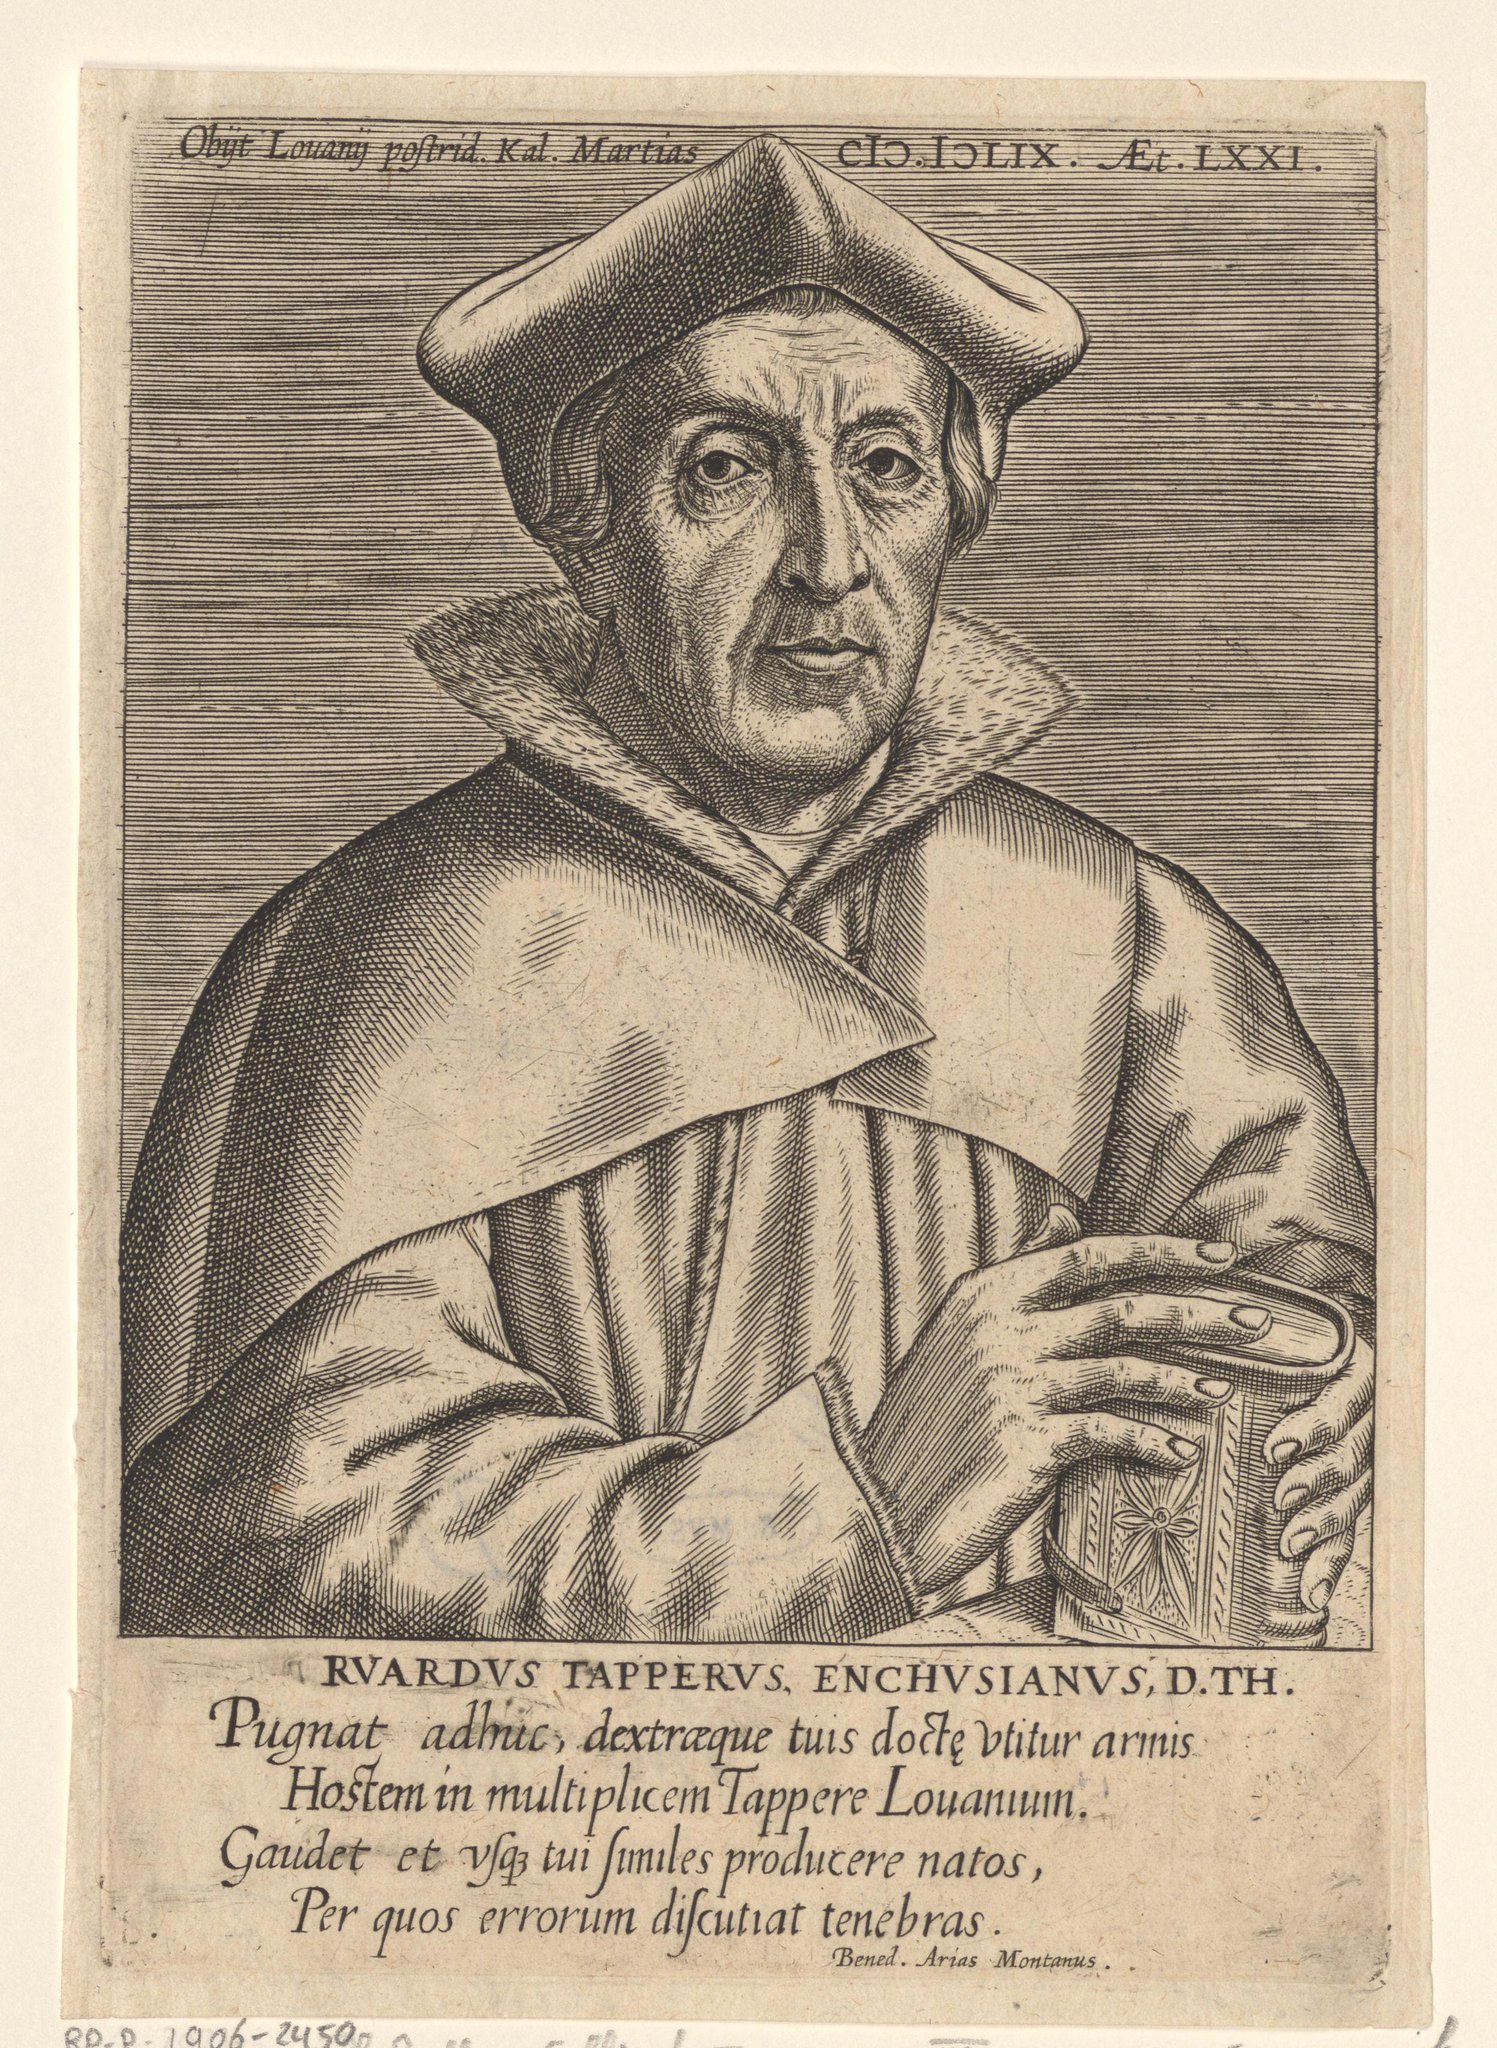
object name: print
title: Portret van Ruard Tapper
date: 1608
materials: paper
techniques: engraving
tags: enkhuizen, cardinal, historical persons, book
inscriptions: collector's mark: Lugt 2228